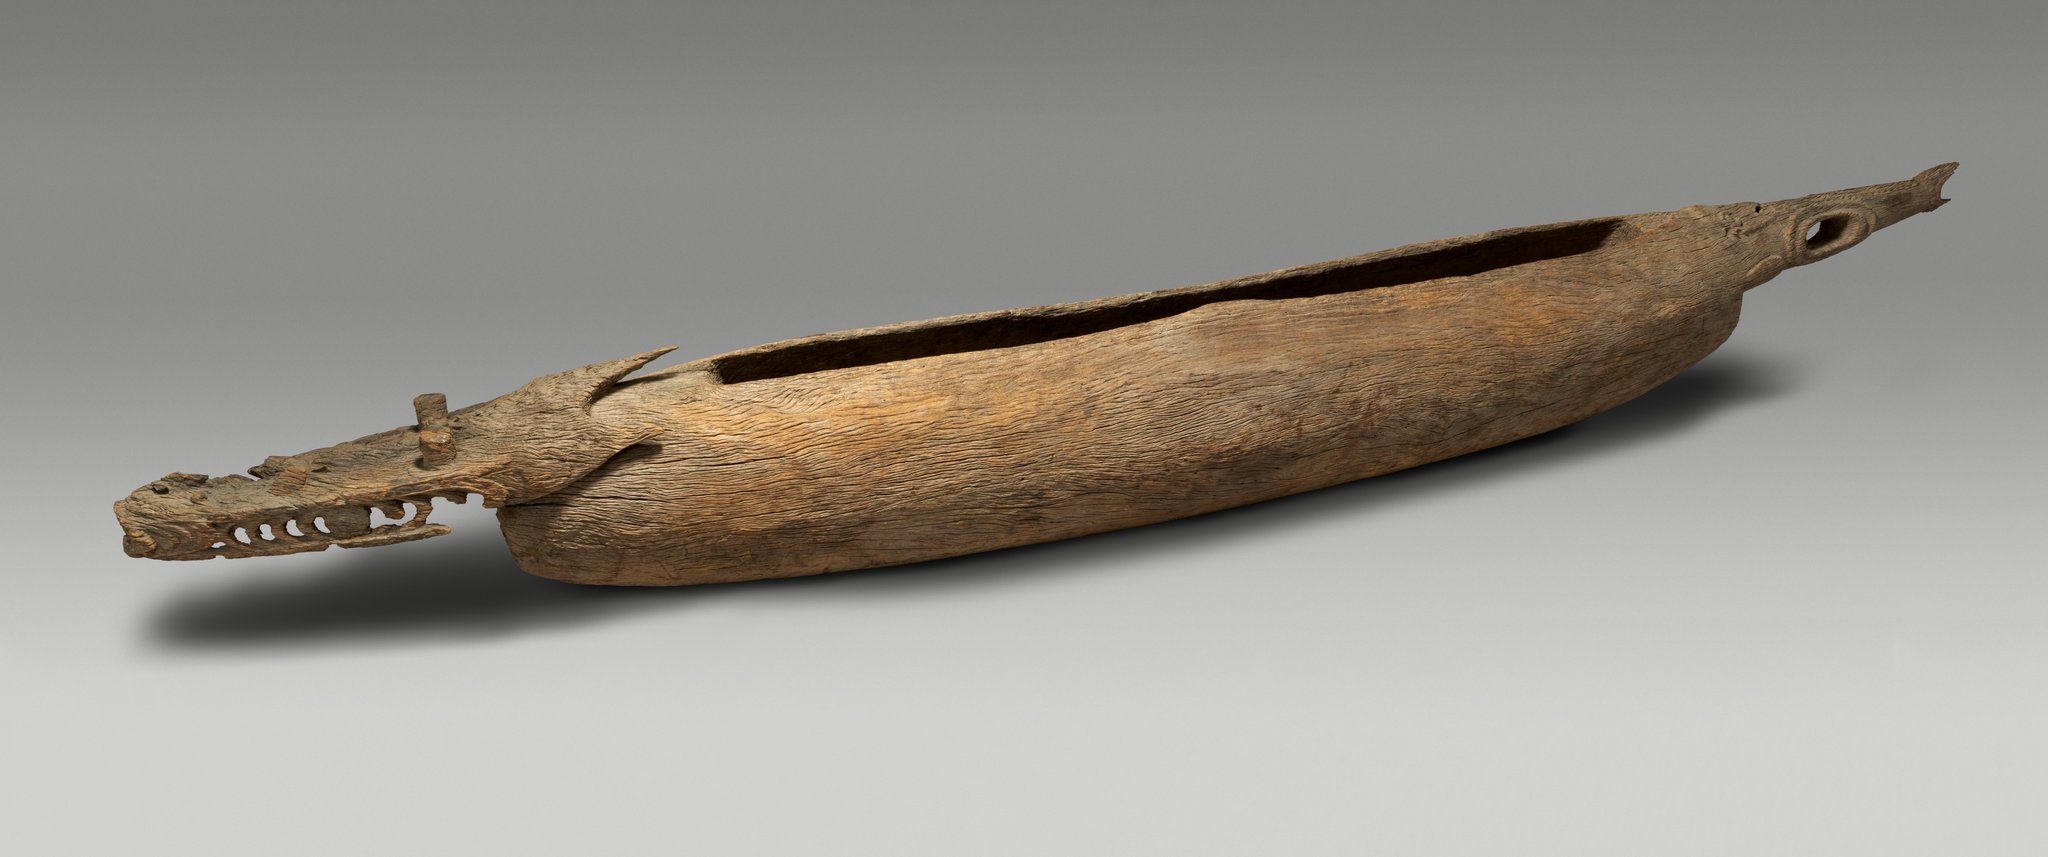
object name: slit gong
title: Sacred Slit Gong (Waken)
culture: iatmul people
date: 1801-1900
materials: wood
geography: papua new guinea